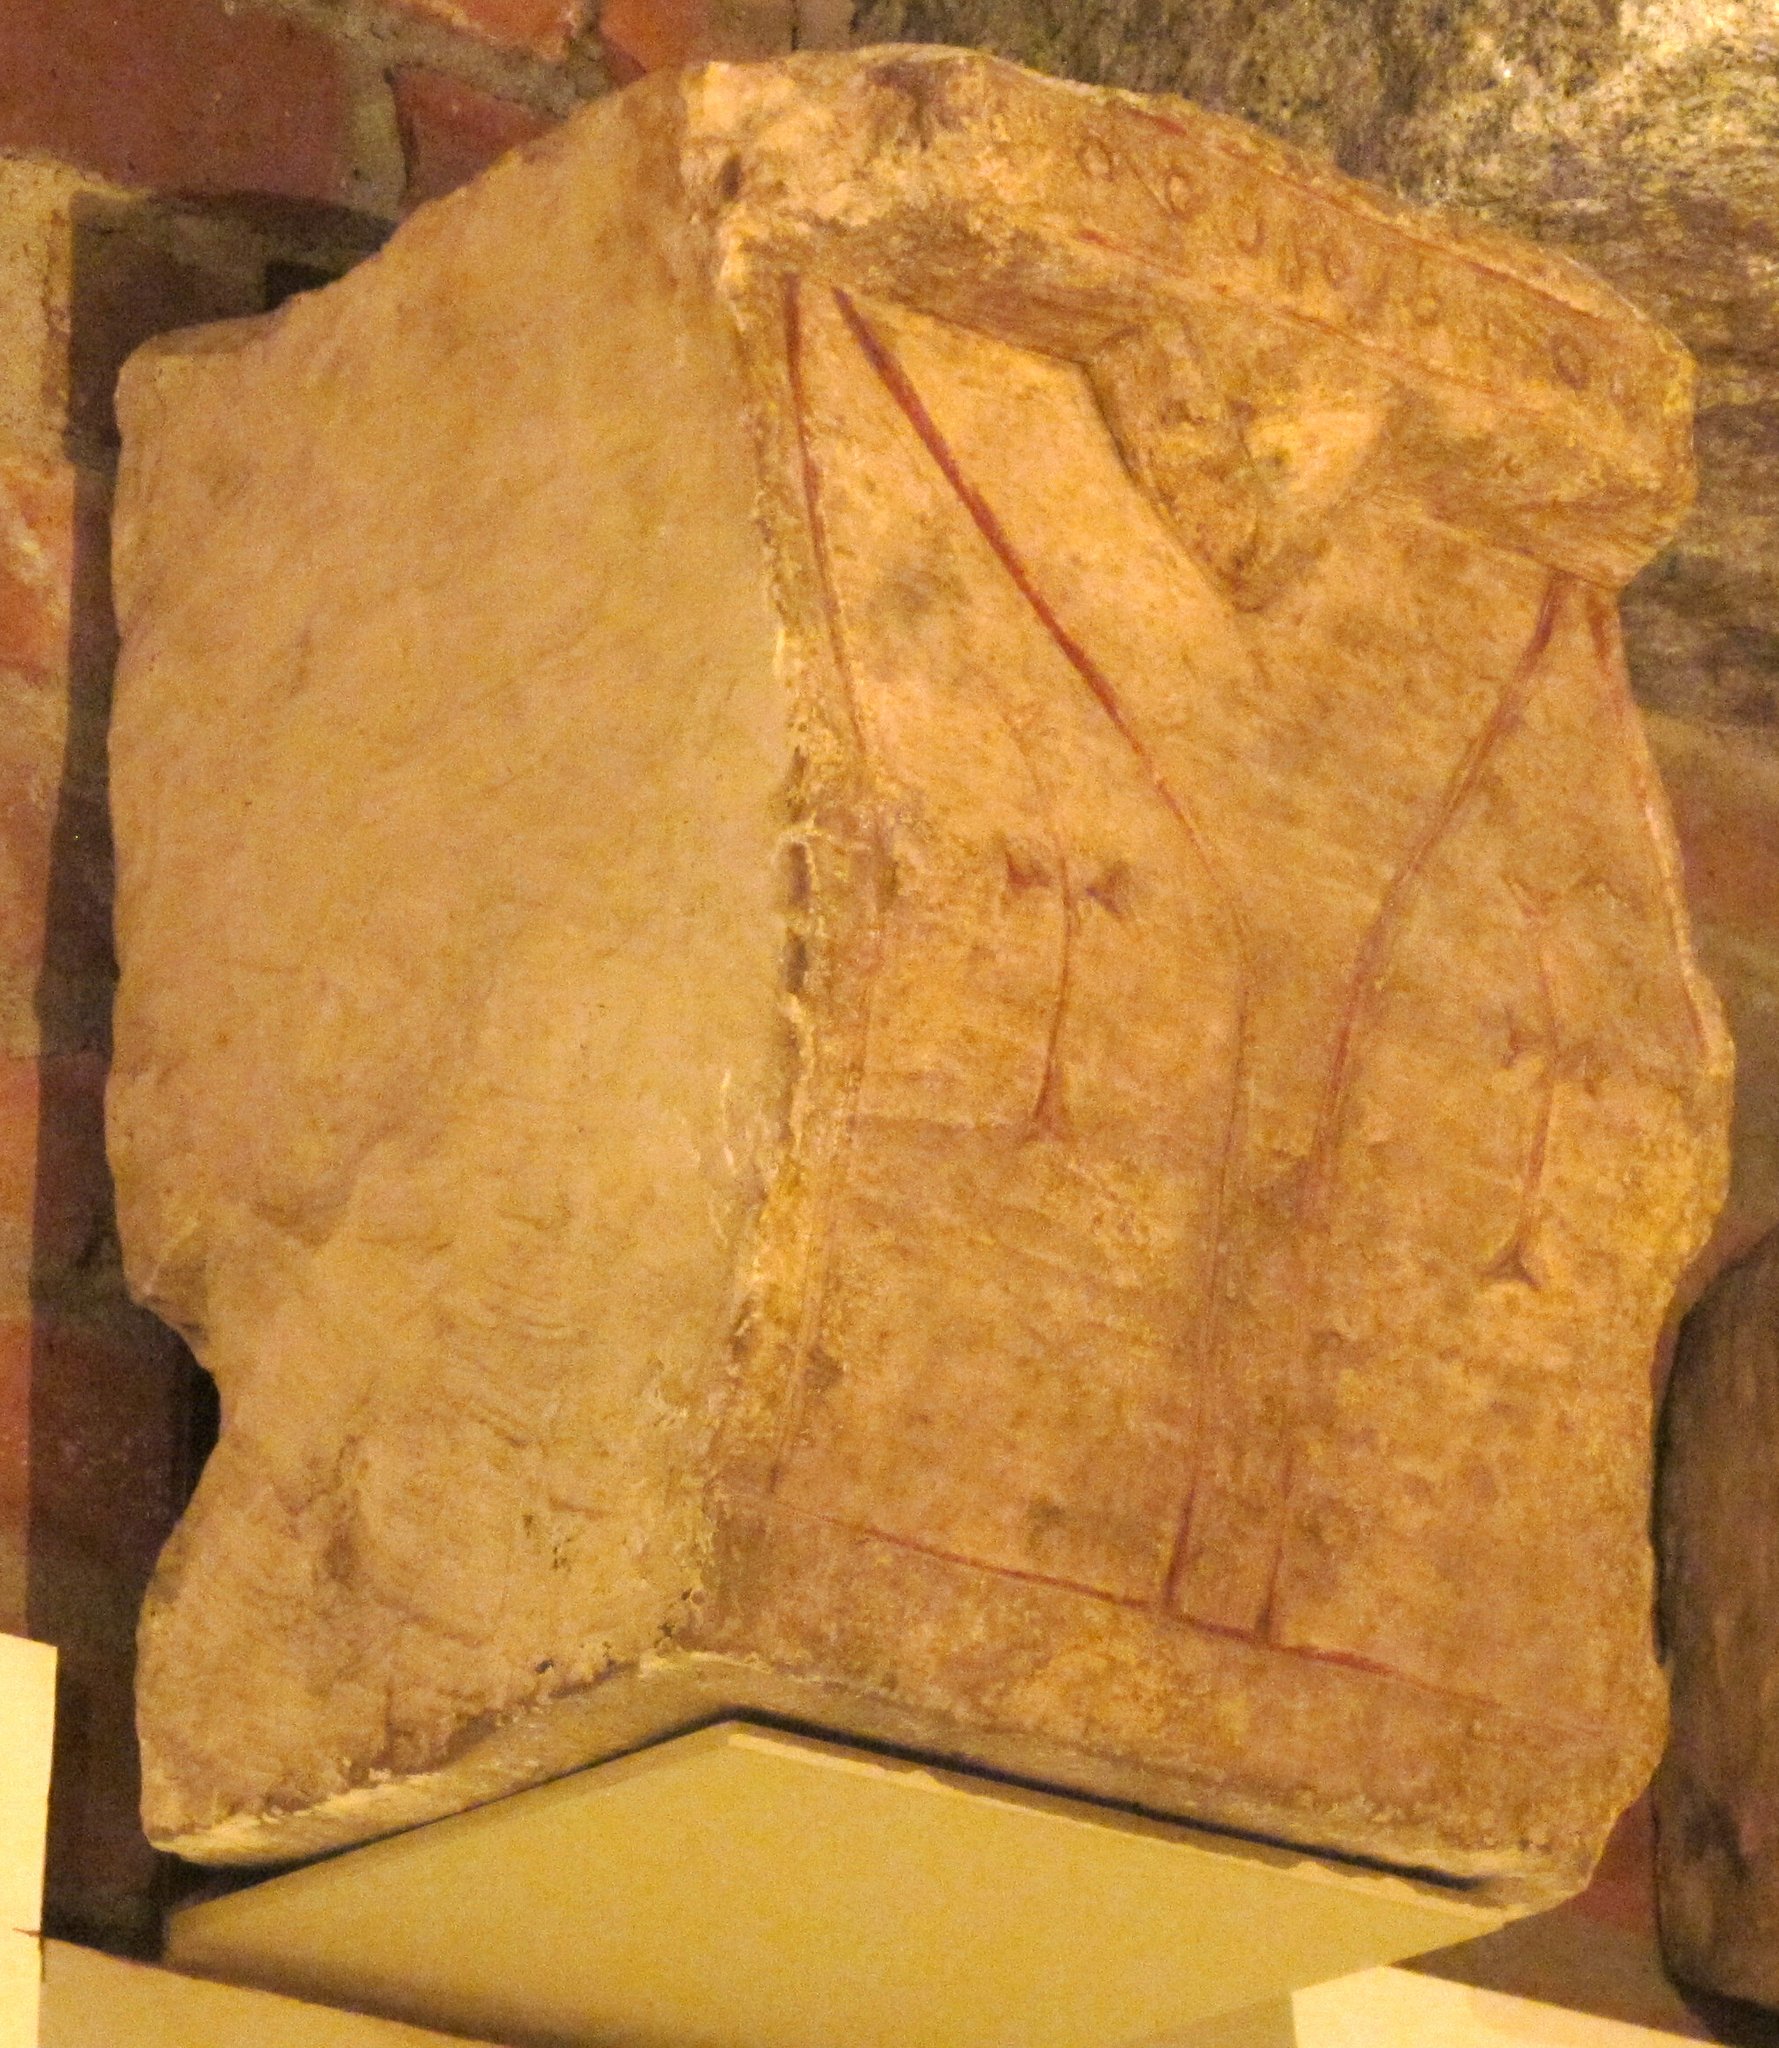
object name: console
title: Console with Incised Lines and Crosses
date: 501-700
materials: limestone, pigment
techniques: incising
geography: egypt